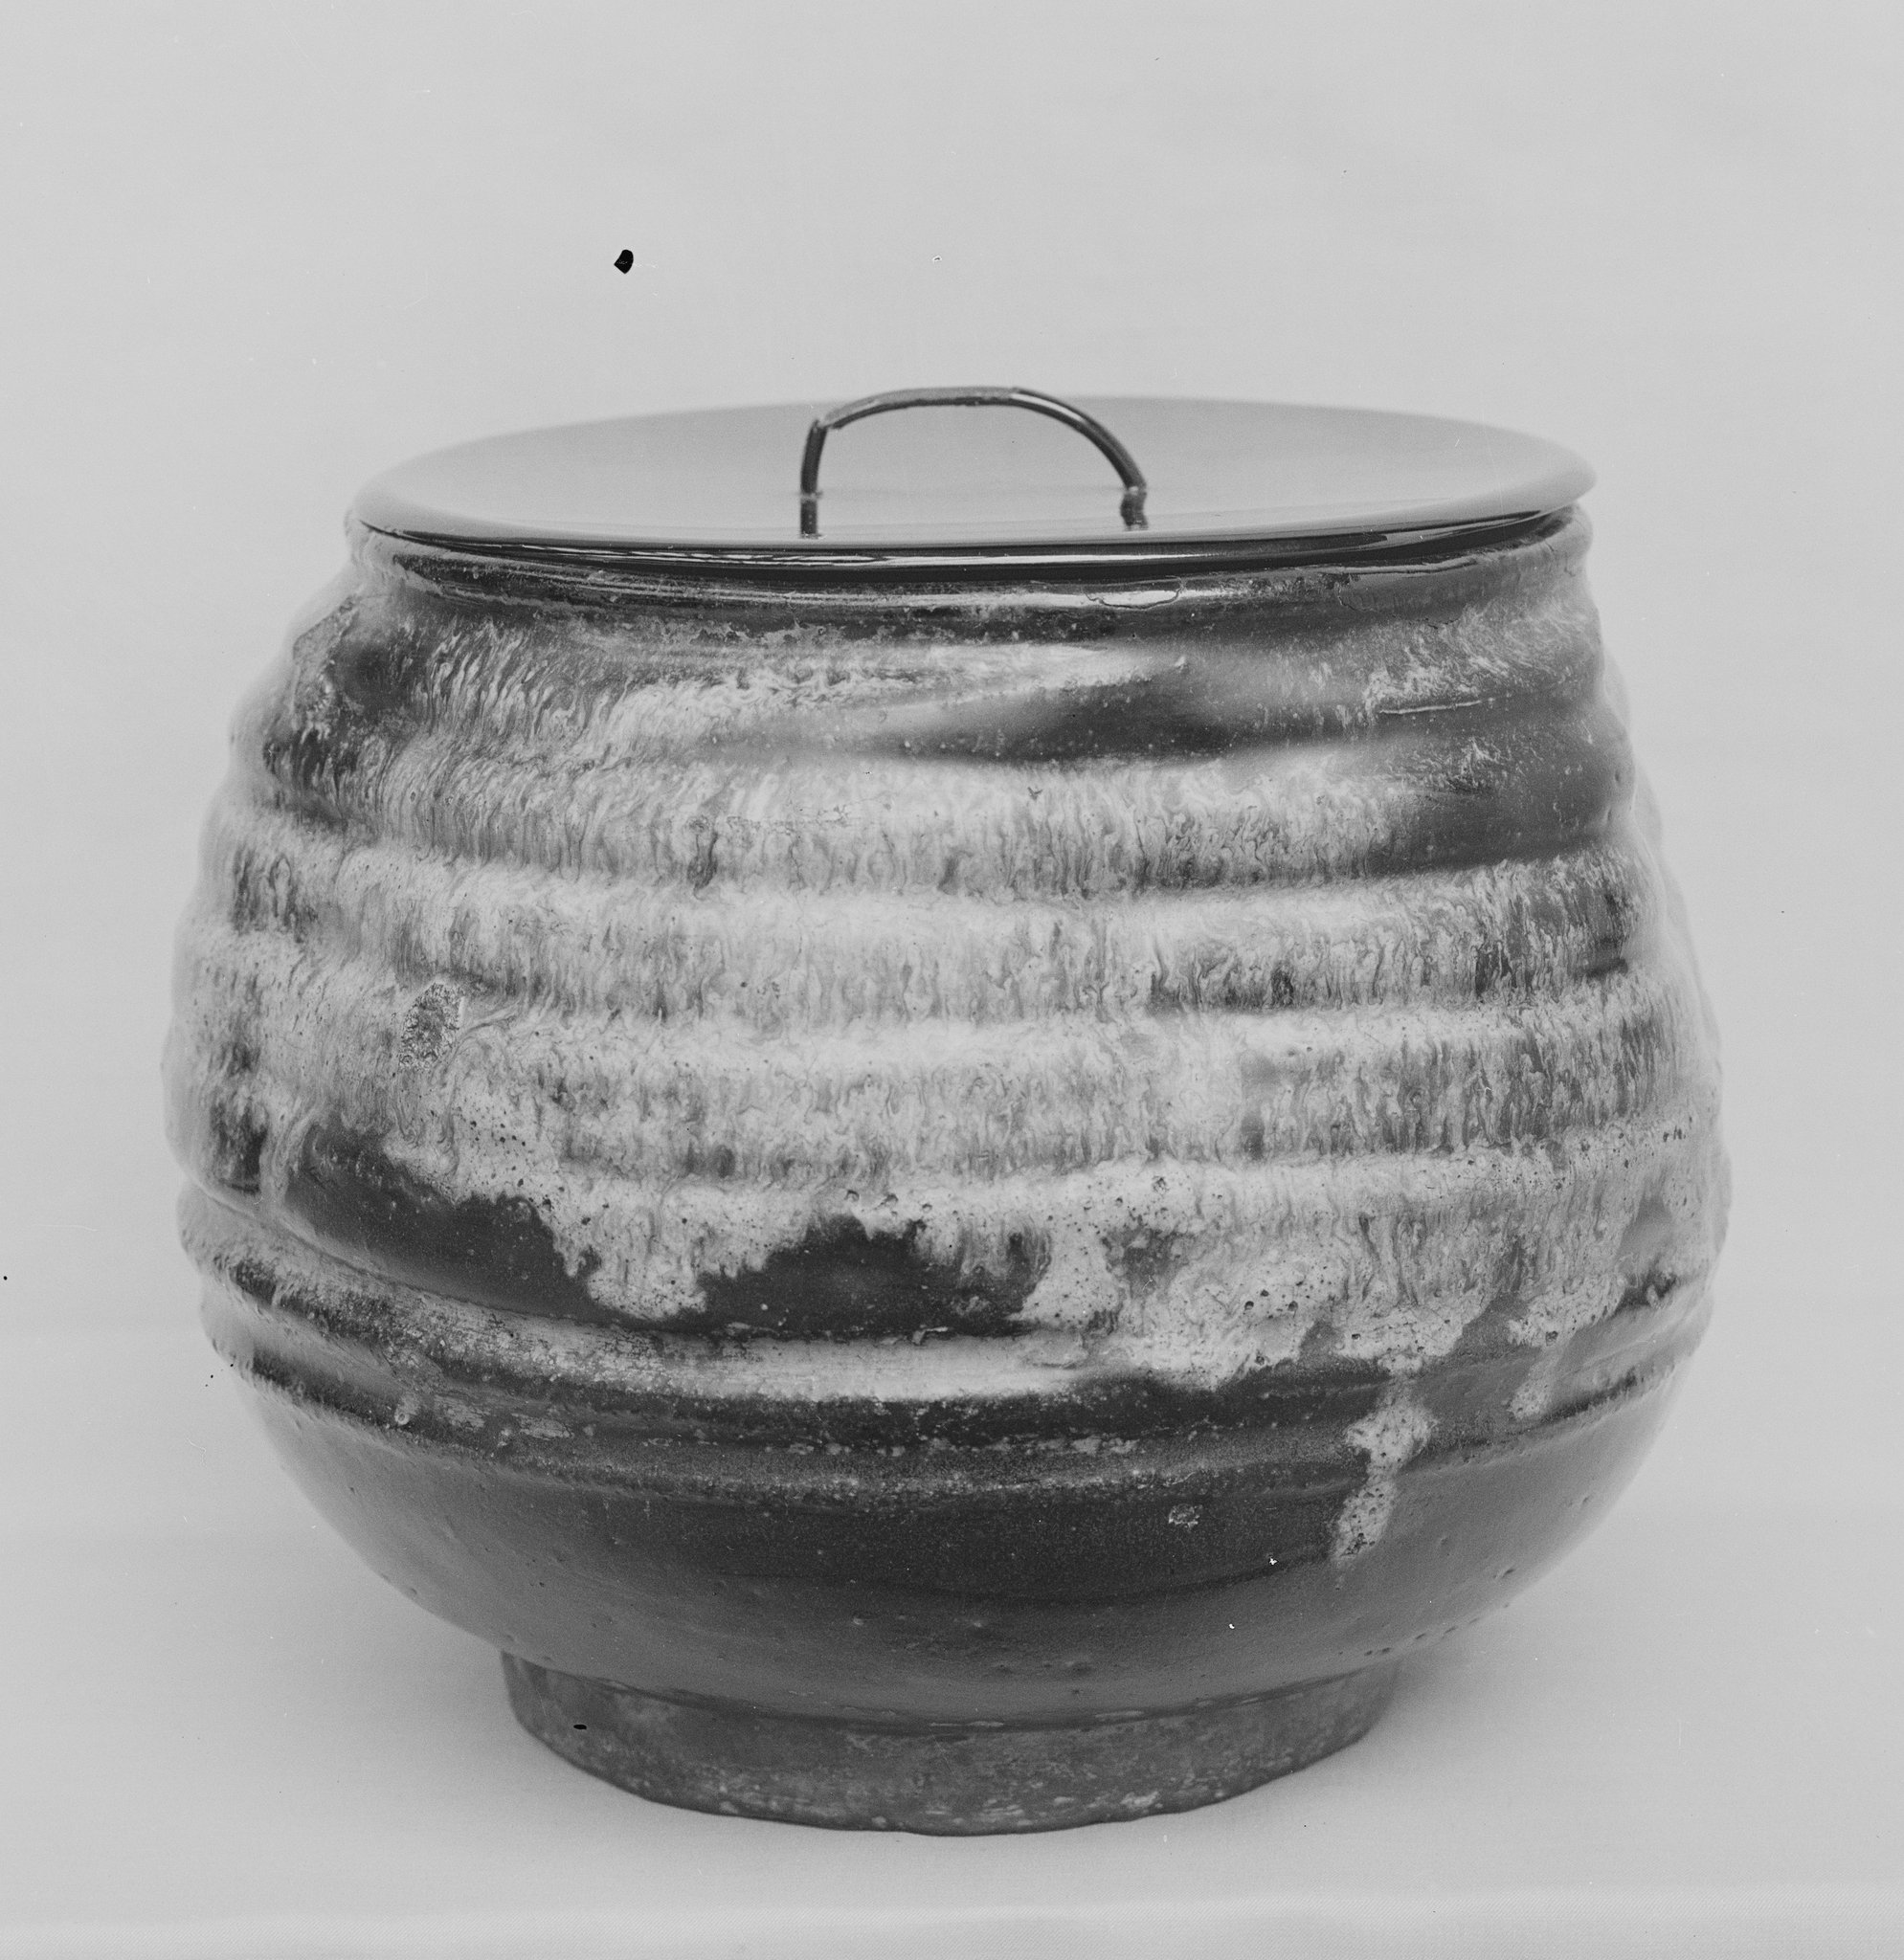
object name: water pot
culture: japanese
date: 1701-1800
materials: clay, glaze, lacquer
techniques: overglaze